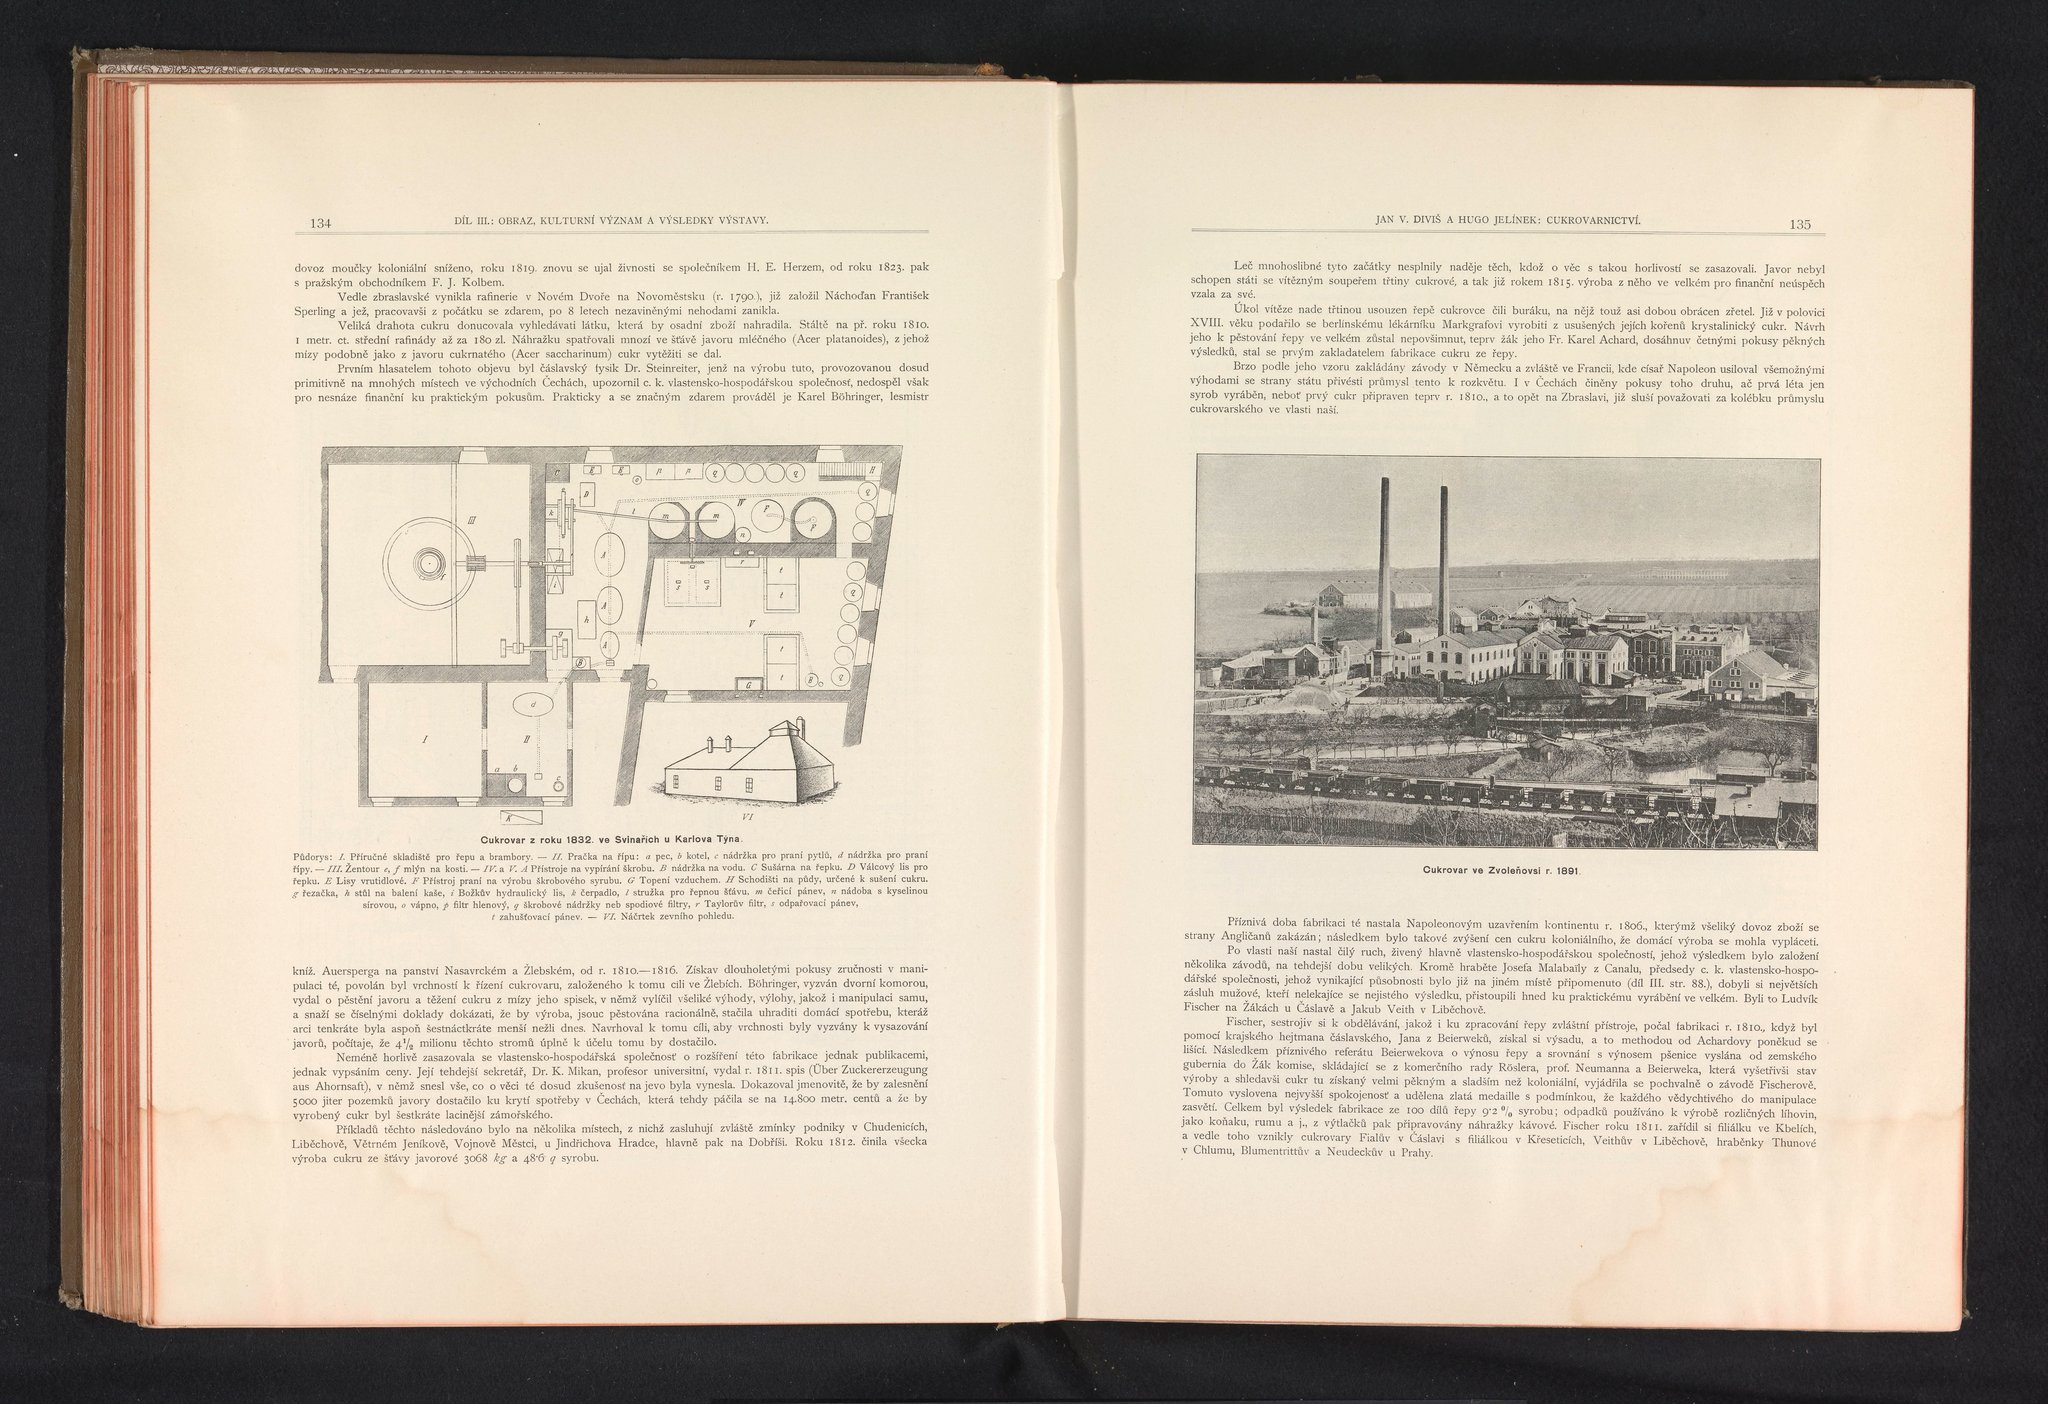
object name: photomechanical print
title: Cukrovar ve Zvolenovsi r. 1891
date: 1891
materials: paper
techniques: autotype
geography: prague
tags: factory-building, sugar